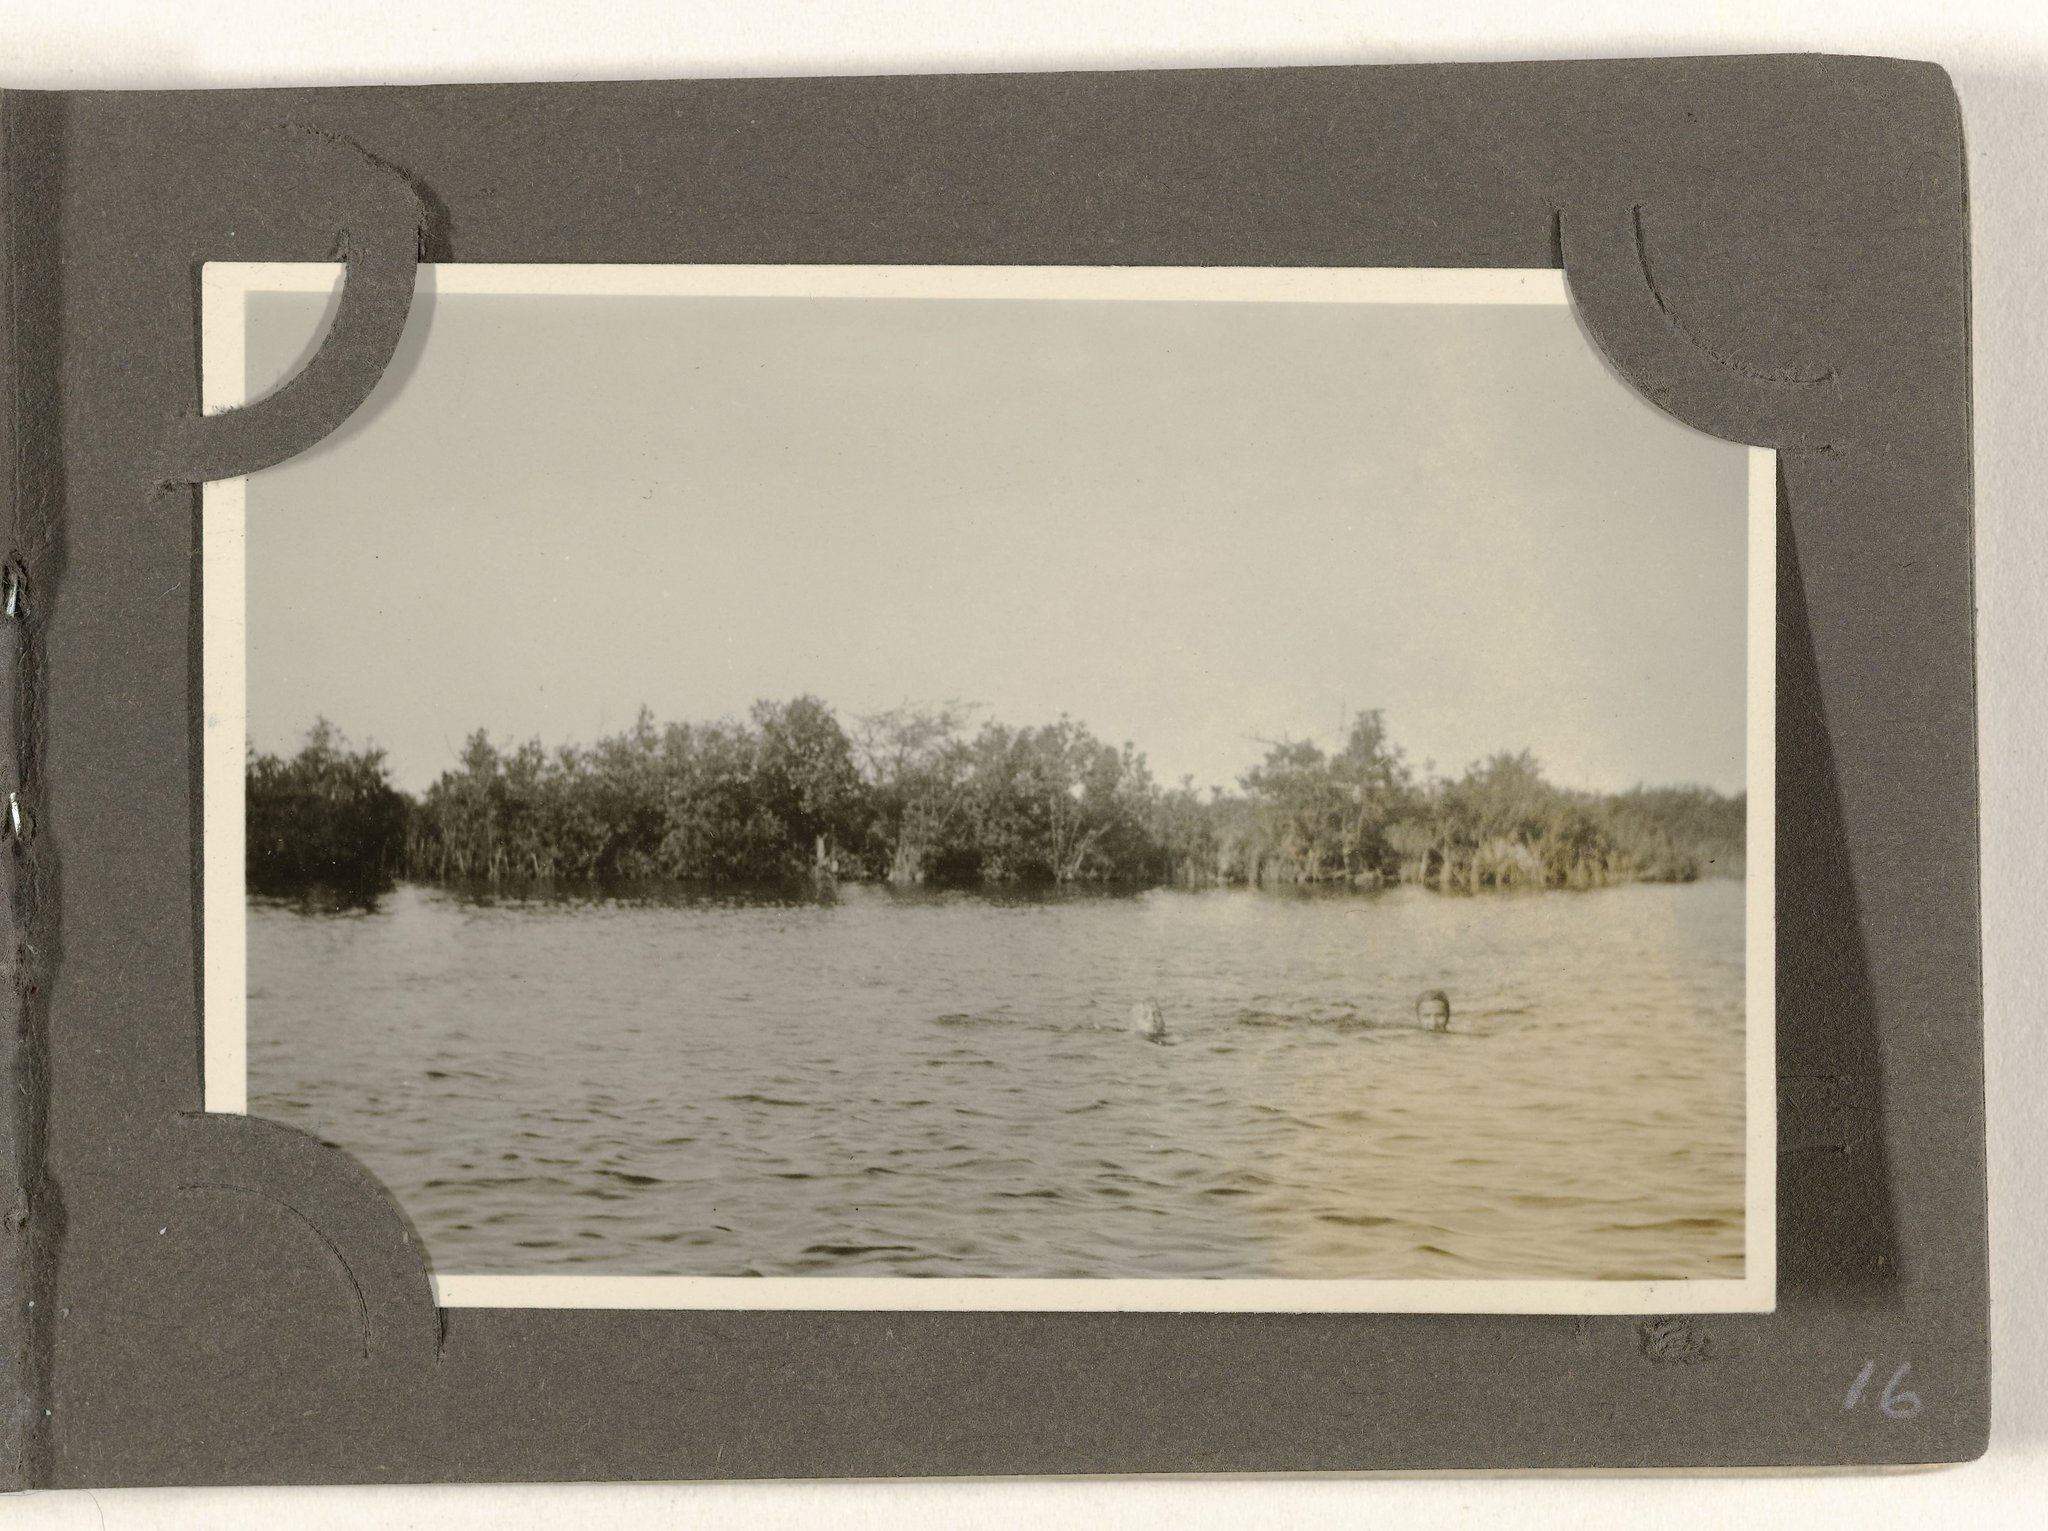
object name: photograph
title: Zwemmen in een meer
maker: Anonymous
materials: photographic support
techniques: gelatin silver print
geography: rotterdam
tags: wim van den bosch, rotterdam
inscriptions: date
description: Twee personen zwemmend in het water van een meer. Opname gemaakt tussen 14-21 augustus 1943. Onderdeel van het familiealbum 1933-1944.